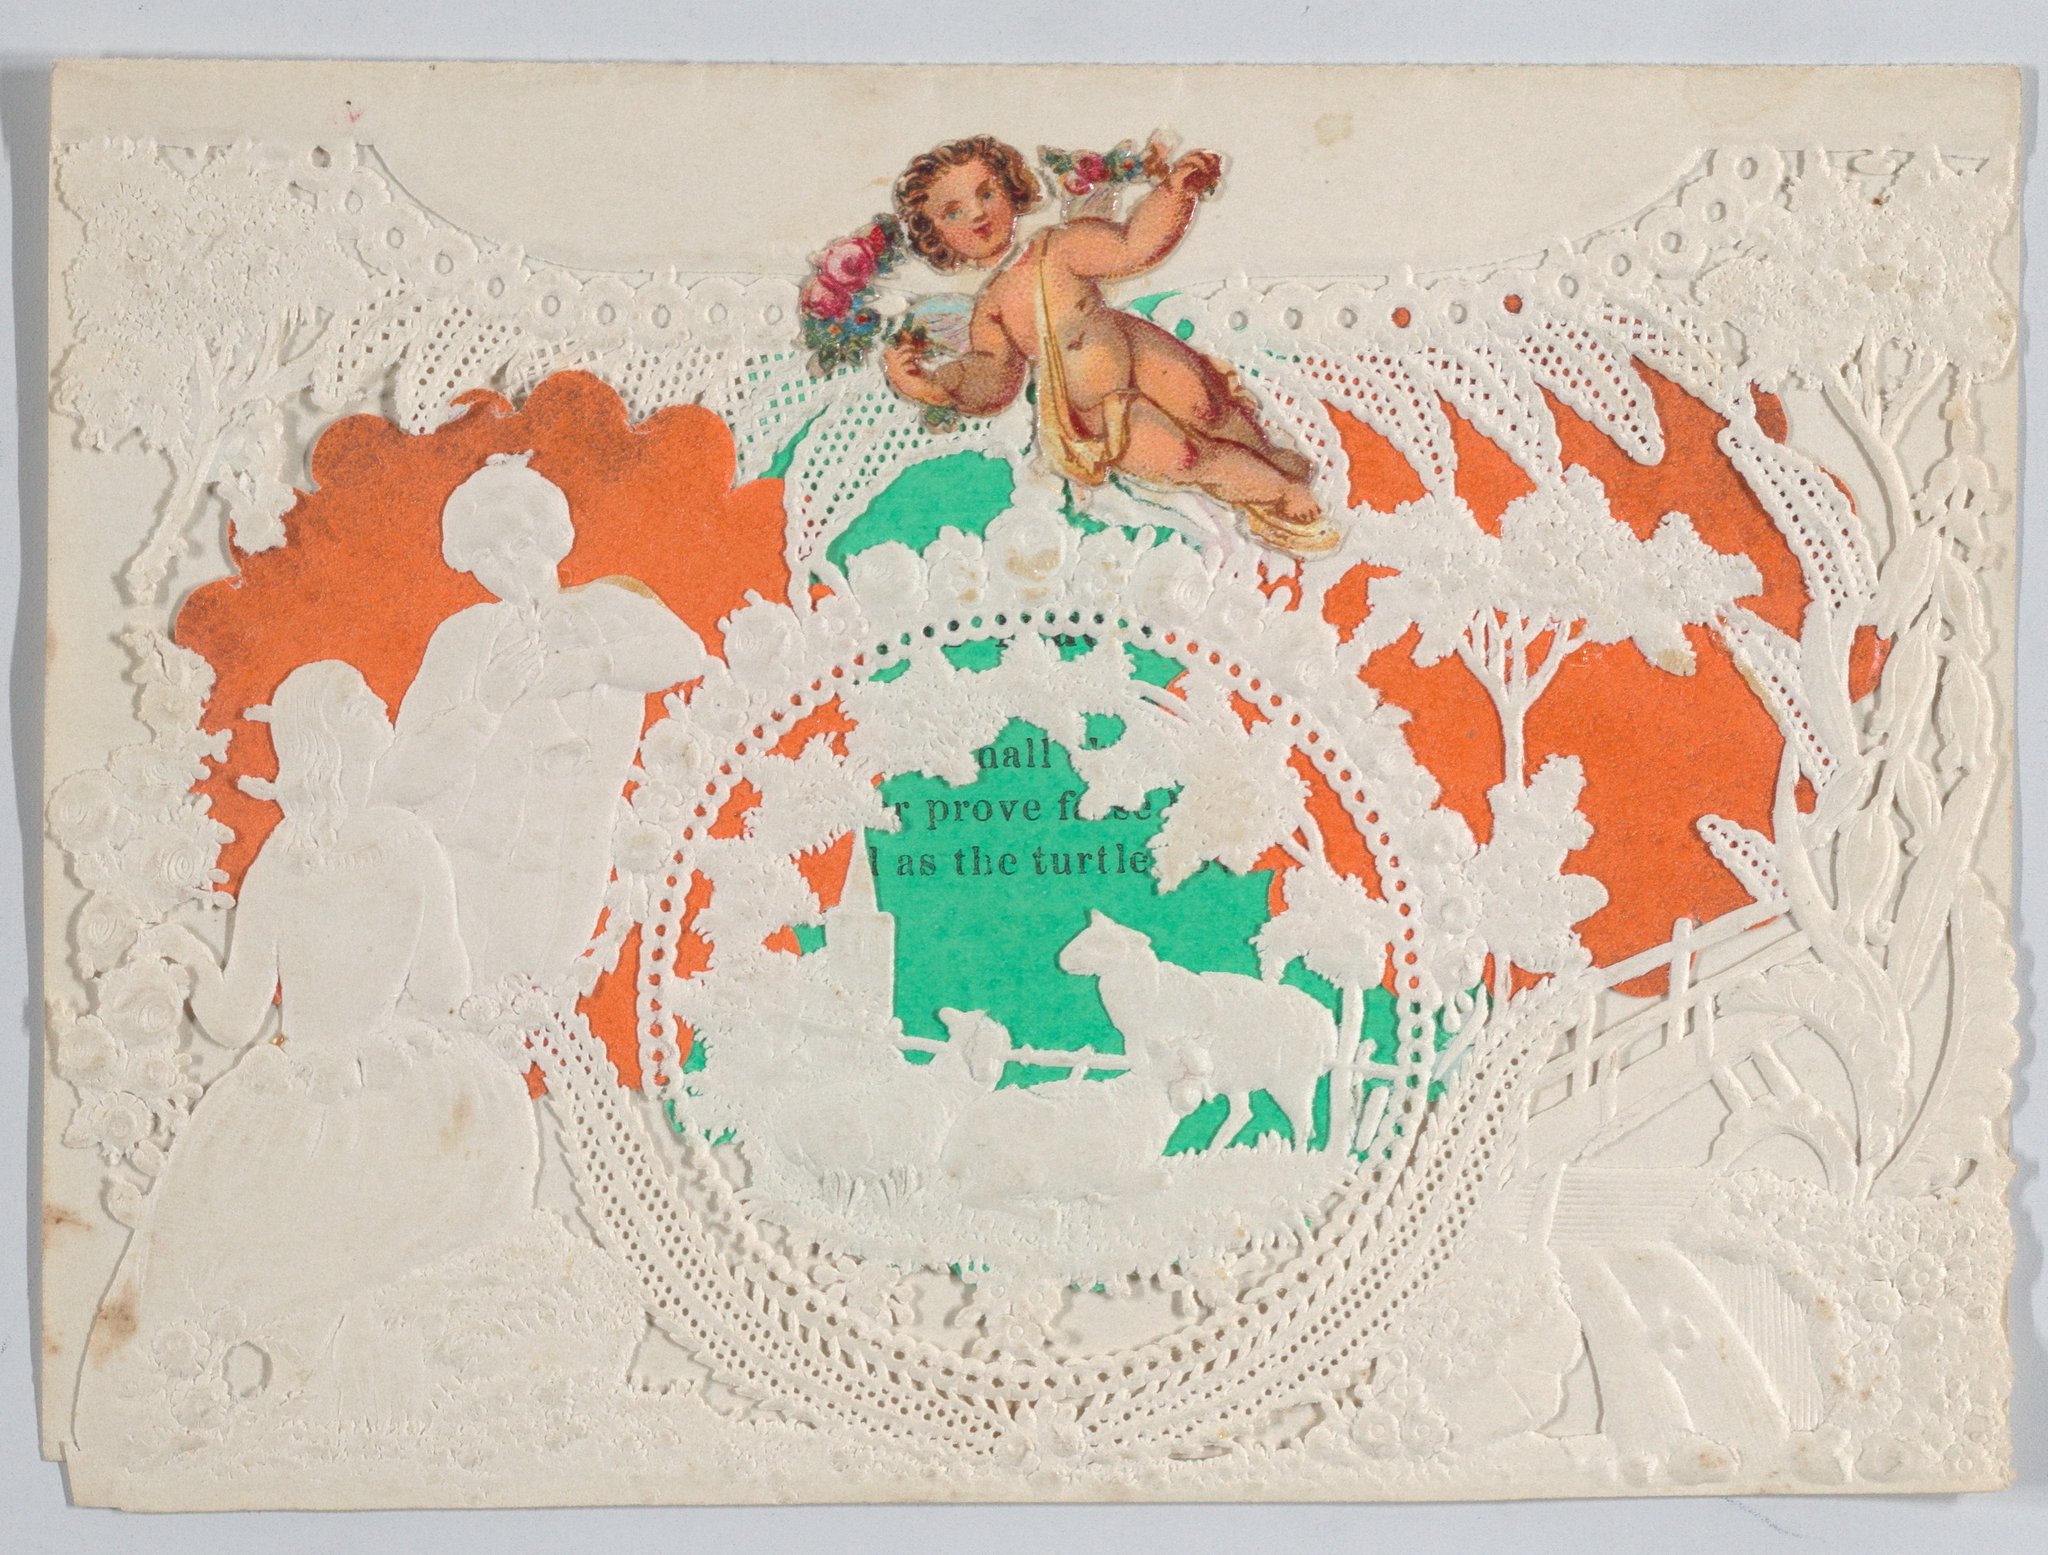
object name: valentine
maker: Anonymous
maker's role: artist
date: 1850-1870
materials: lace, paper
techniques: embossing, open work